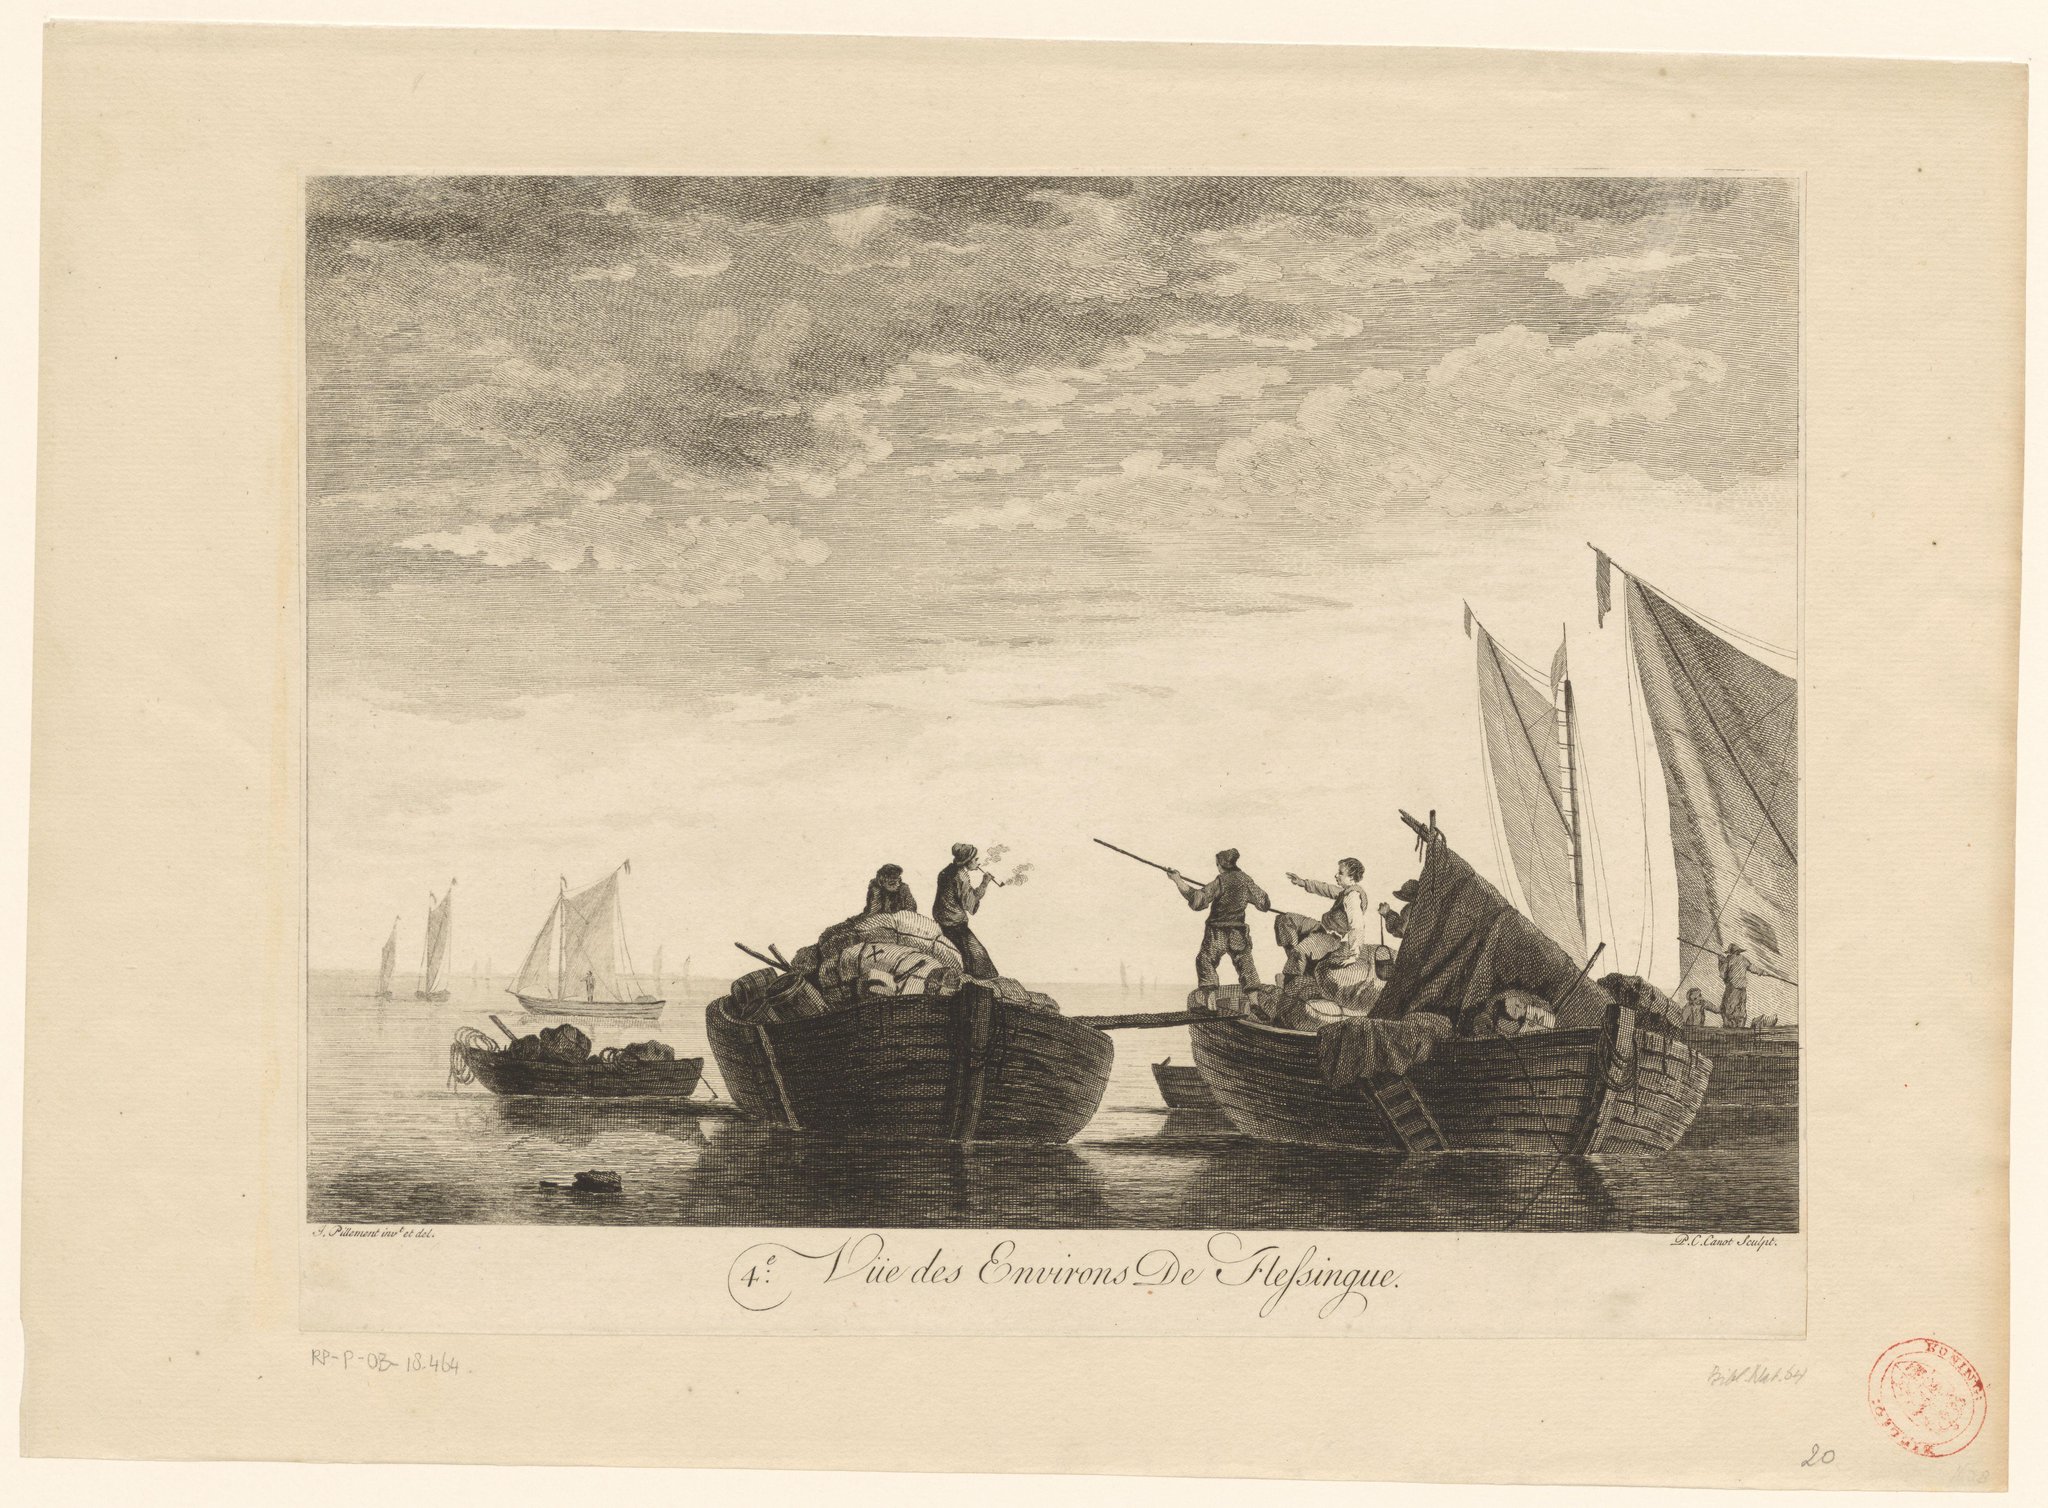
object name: print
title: Gezichten op Vlissingen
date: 1738-1761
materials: paper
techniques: engraving, etching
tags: harbouring (+ number of persons ~ traffic and transport), pipe ~ tobacco, flushing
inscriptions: collector's mark: Lugt 240, collector's mark: Lugt 1838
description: Deze prent maakt deel uit van een serie van vier prenten.